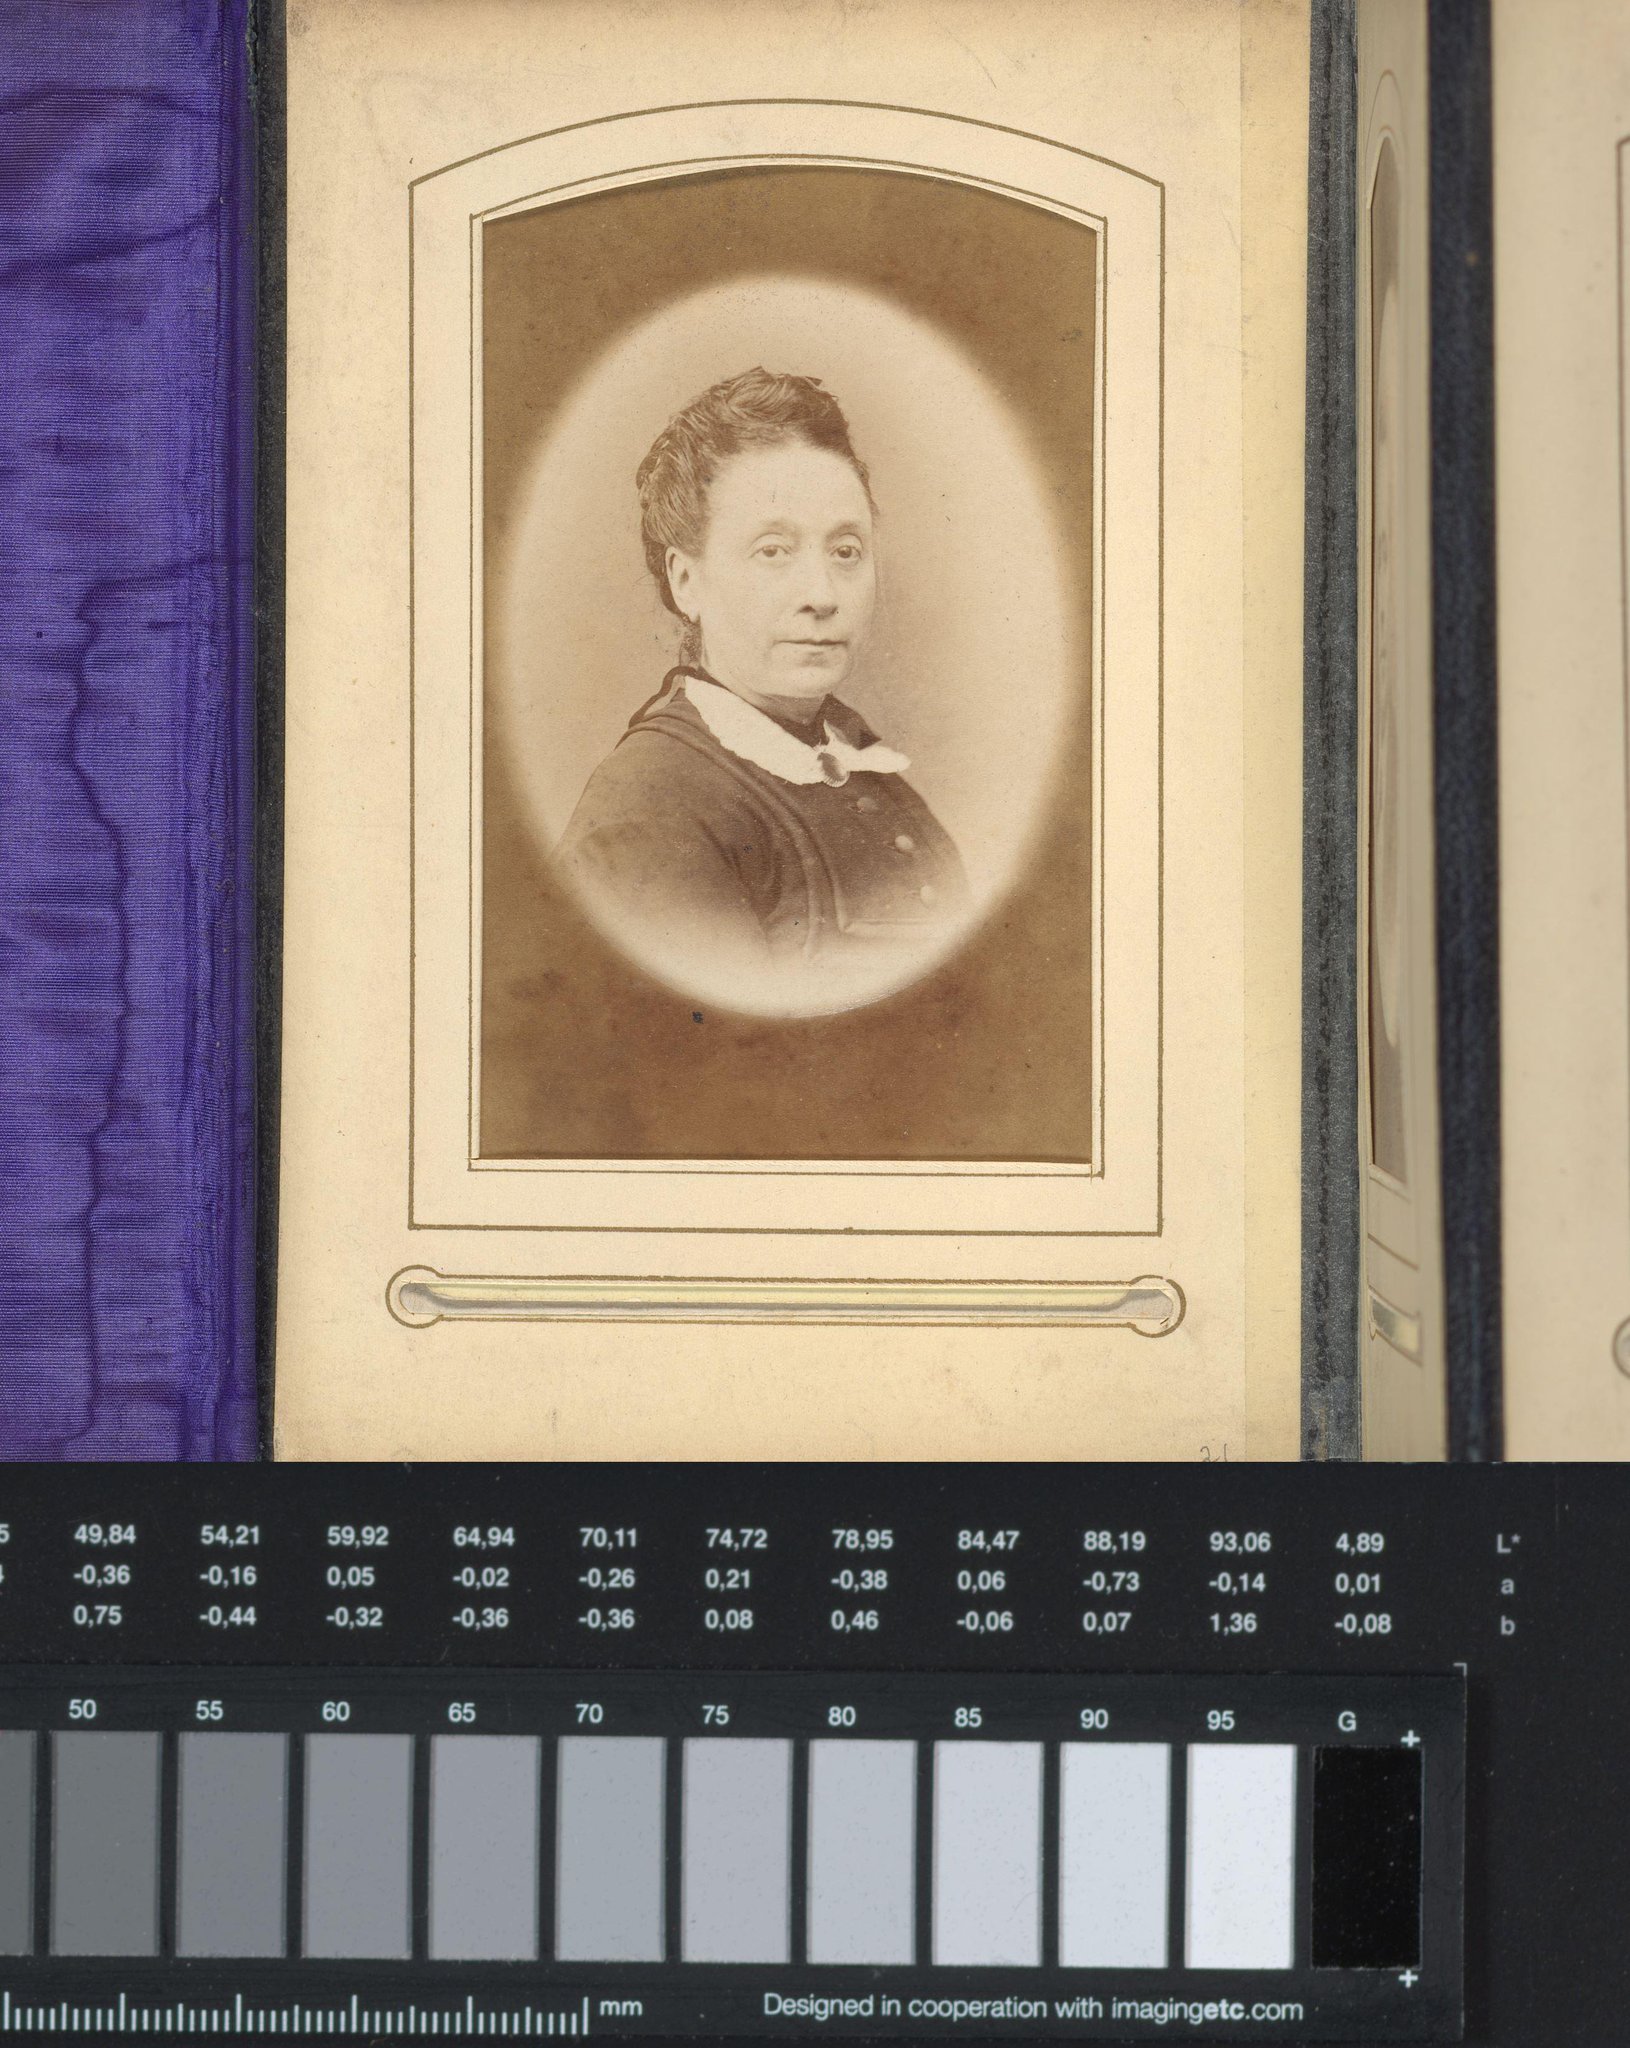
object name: photograph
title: Portret van een vrouw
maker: ed. radermacher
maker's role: fotograaf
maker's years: 1839-1908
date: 1863-1890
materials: cardboard, photographic support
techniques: albumen print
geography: rotterdam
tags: historical persons - bb - woman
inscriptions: inscription: ‘ED. RADERMACHER/ PHOTOGRAPH/ FIRMA/ (JANSSENS & RADERMACHER)/ KRUISKADE, HOEK KERKLAAN/ ROTTERDAM’